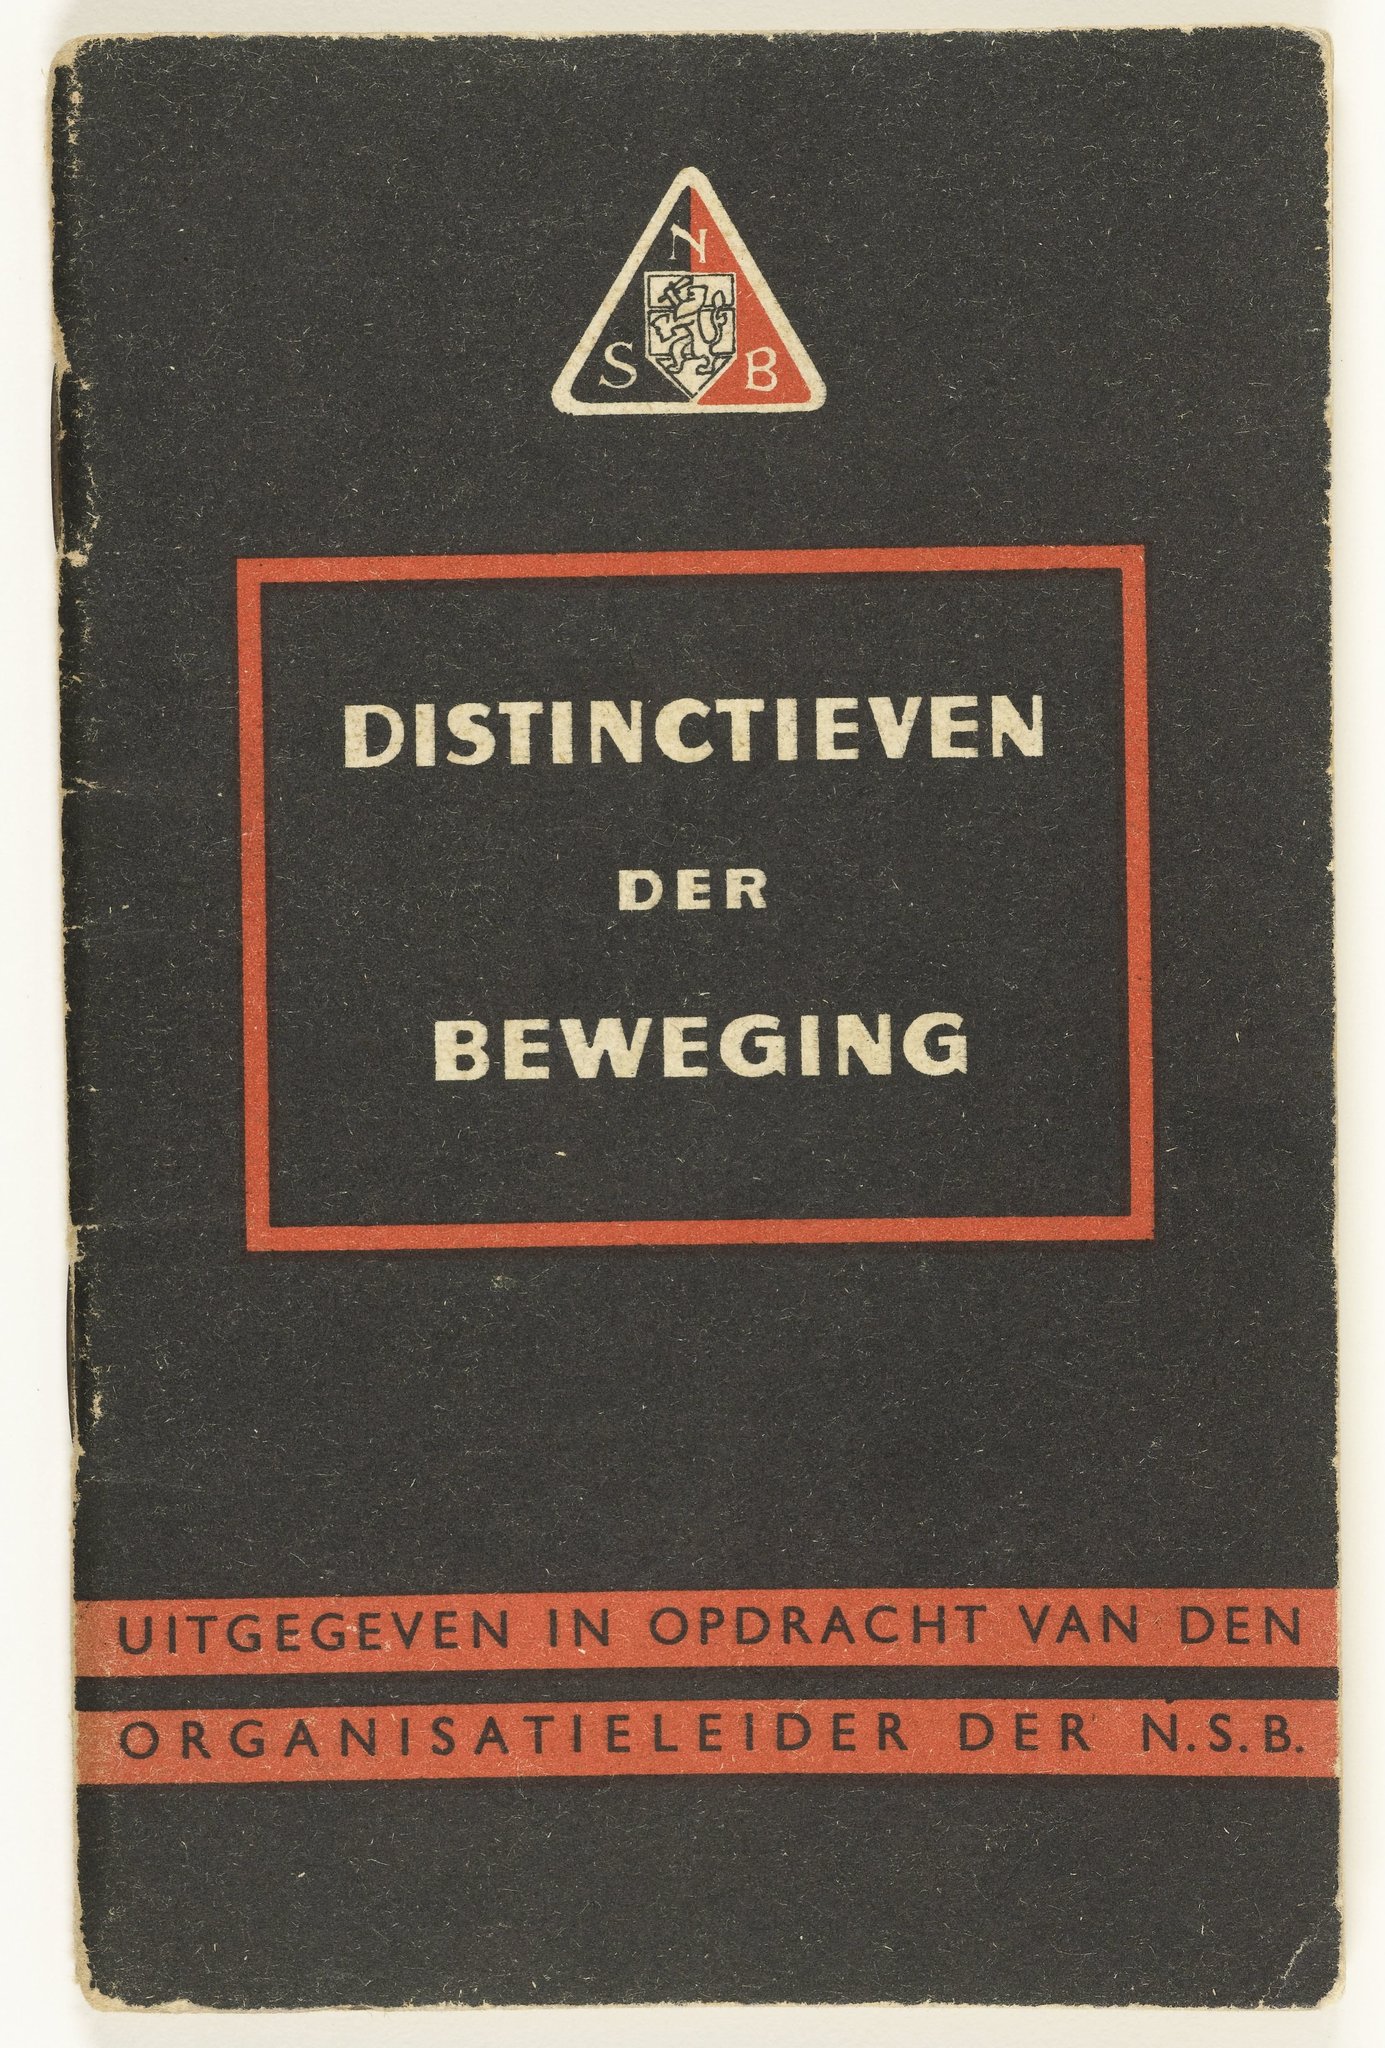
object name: book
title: Distinctieven der beweging NSB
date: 1940-1942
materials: metal, paper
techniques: printing, stapling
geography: netherlands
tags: netherlands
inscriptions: title: ‘DISTINCTIEVEN DER BEWEGING UITGEGEVEN IN OPDRACHT VAN DEN ORGANISATIELEIDER DER N.S.B.’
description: Klein boekje waarin de distinctieven van de NSB zijn afgebeeld met onderschrift. Omslag in zwart en rood gedrukt en 32 pagina's binnenwerk in kleur.